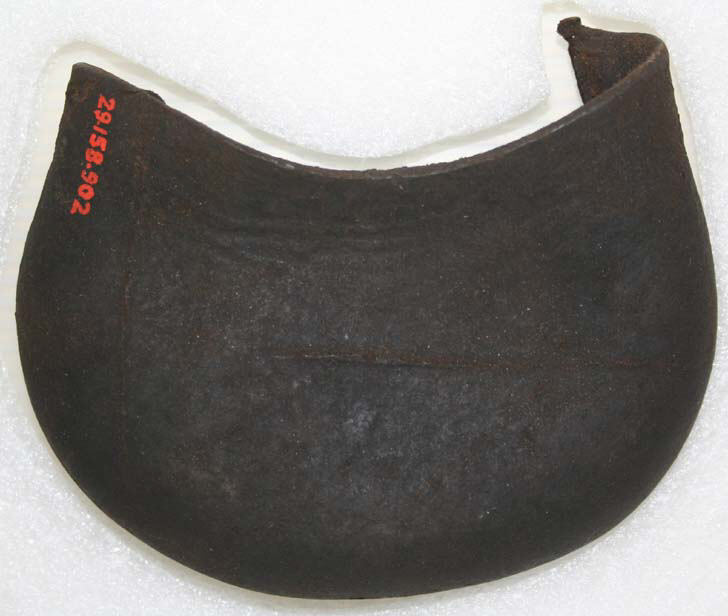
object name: shoe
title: Shoes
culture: british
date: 1501-1600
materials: leather